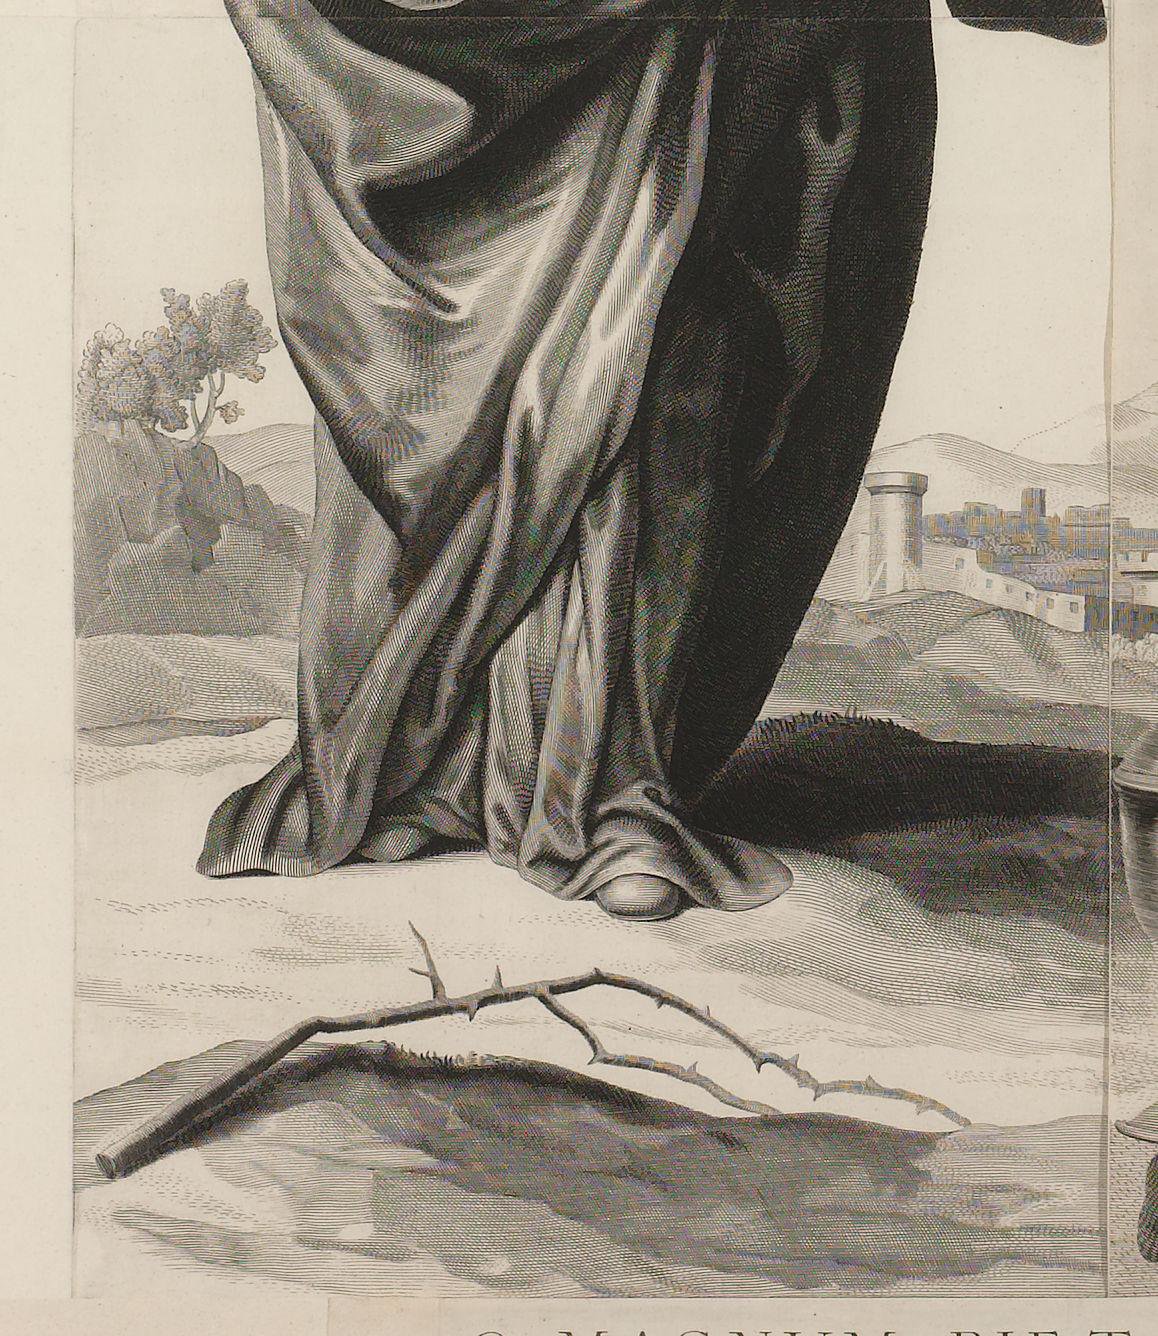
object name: print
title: Gekruisigde Christus met Maria, Johannes en Maria Magdelena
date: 1650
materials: paper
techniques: engraving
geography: antwerp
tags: crucified christ with mary, john, and mary magdalene, cupids: 'amores', 'amoretti', 'putti'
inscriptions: collector's mark: Lugt 240, collector's mark: Lugt 1838